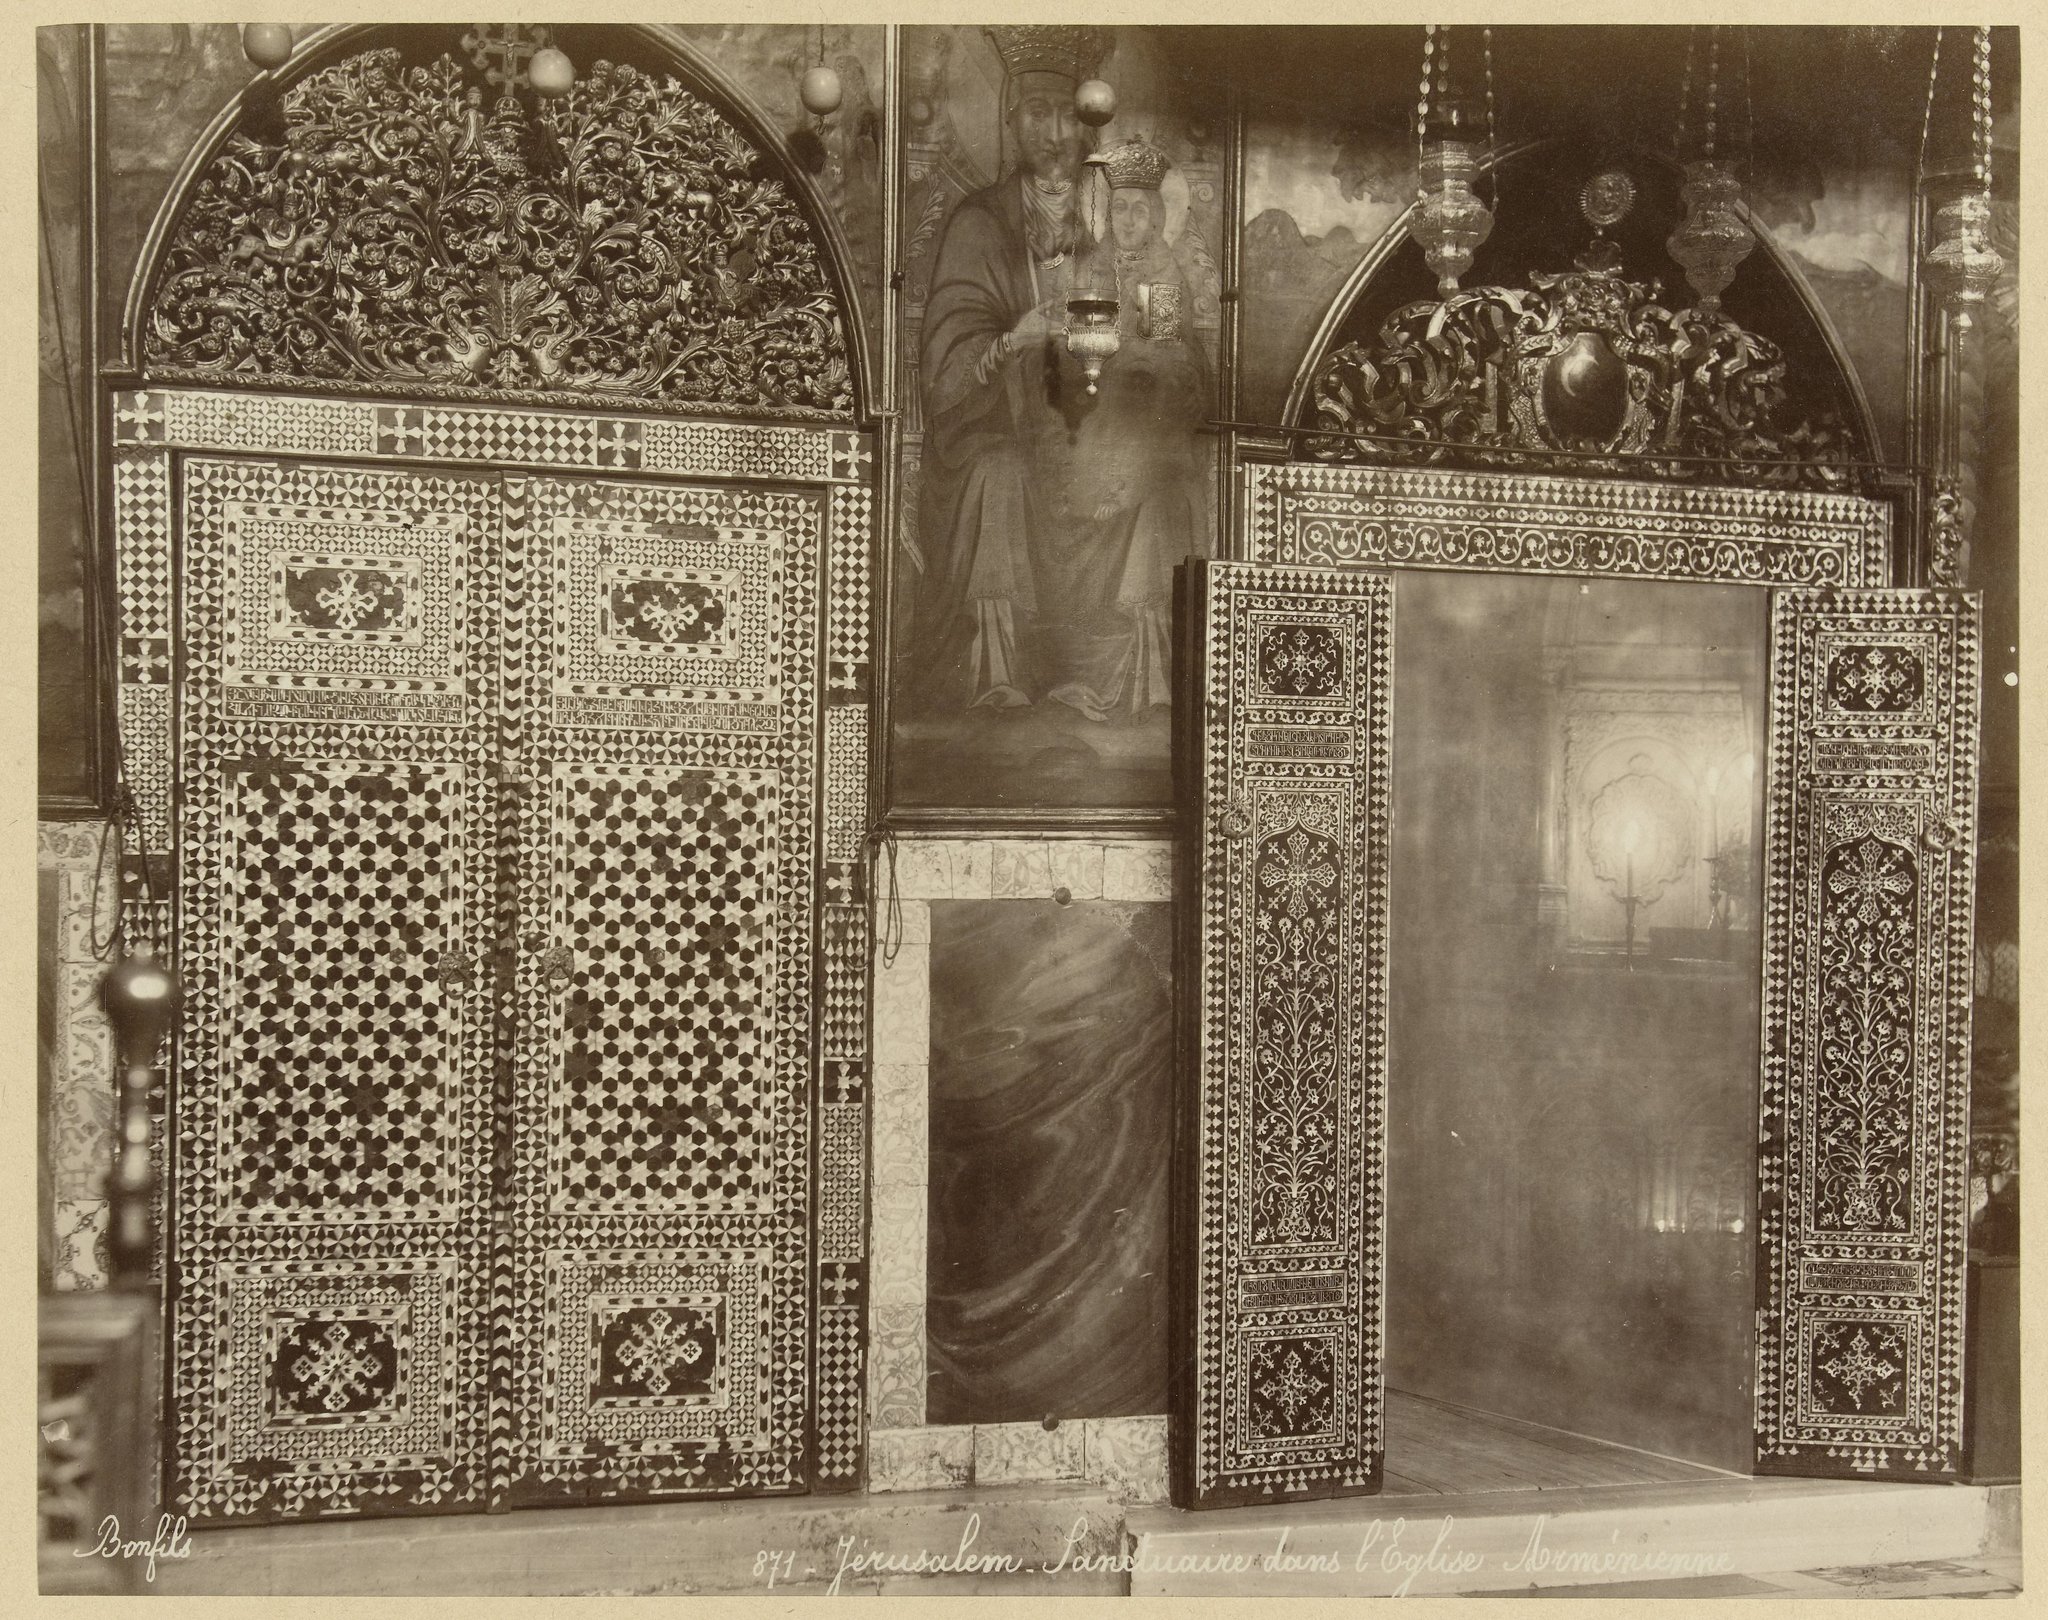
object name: photograph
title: Jérusalem - Sanctuaire dans l'Eglise Arménienne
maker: félix bonfils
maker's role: fotograaf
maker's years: 1831-1885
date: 1867-1877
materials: cardboard, paper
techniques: albumen print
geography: jerusalem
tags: the early christian churches, e.g. armenians, copts, syrians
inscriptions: number: ‘871’, inscription: ‘S 25. De sacristy van de groote Armenische kerk. Jeruzalem./ (De deuren zijn van cederhout met paarlemoer ingelegd).’, stamp: ‘Gemeentelijke bibliotheek/ Rotterdam’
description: Onderdeel van een groep door fotograaf Richard Polak op reis verzamelde foto’s. Deze foto is samen met andere op zijn reizen verzamelde foto's tentoongesteld bij de Rotterdamsche Kunstkring (1895), Arti en Amicitiae te Amsterdam (1897-1898?) en Societeit 't Collegie te Kampen (datum vooralsnog onbekend).